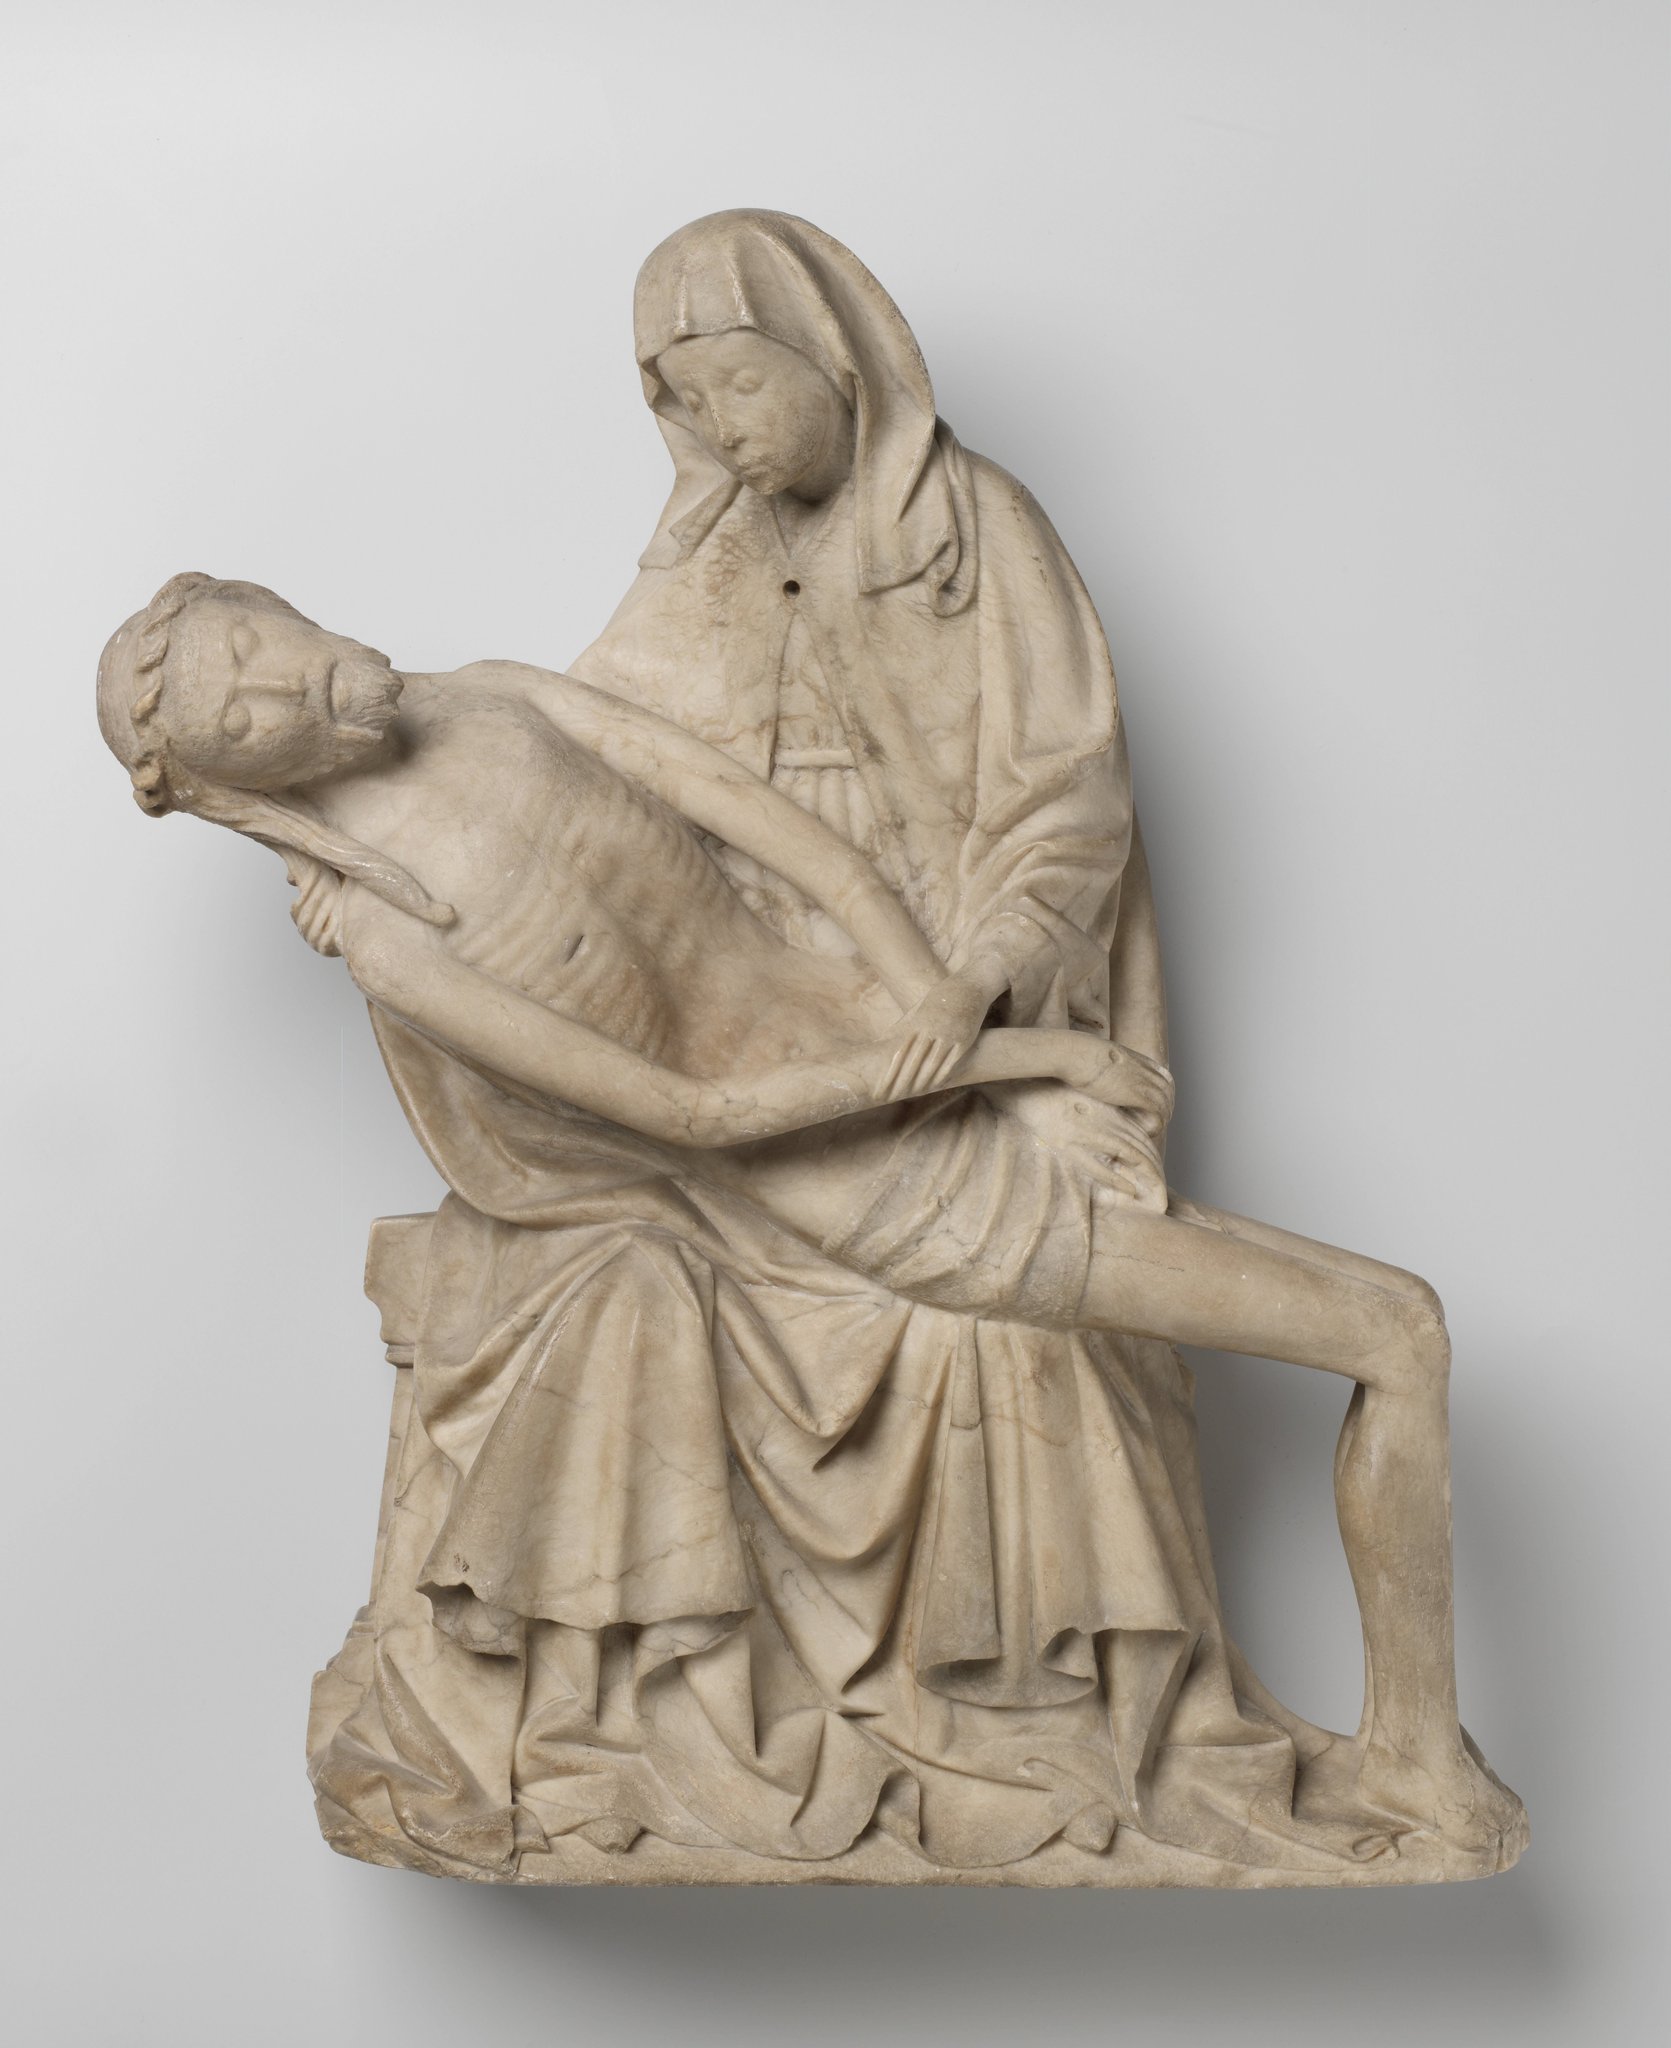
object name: figure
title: Pietà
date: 1450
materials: alabaster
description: Alabaster is a soft rock and therefore highly suitable for refined carved statuary. When polished it acquires a beautiful sheen. This statue was probably once smoothly finished. Moreover, the hem of Mary’s cloak was decorated with gilt. The tiny hole visible just under her chin may have once held a (semi-)precious stone as a clasp for her cloak.